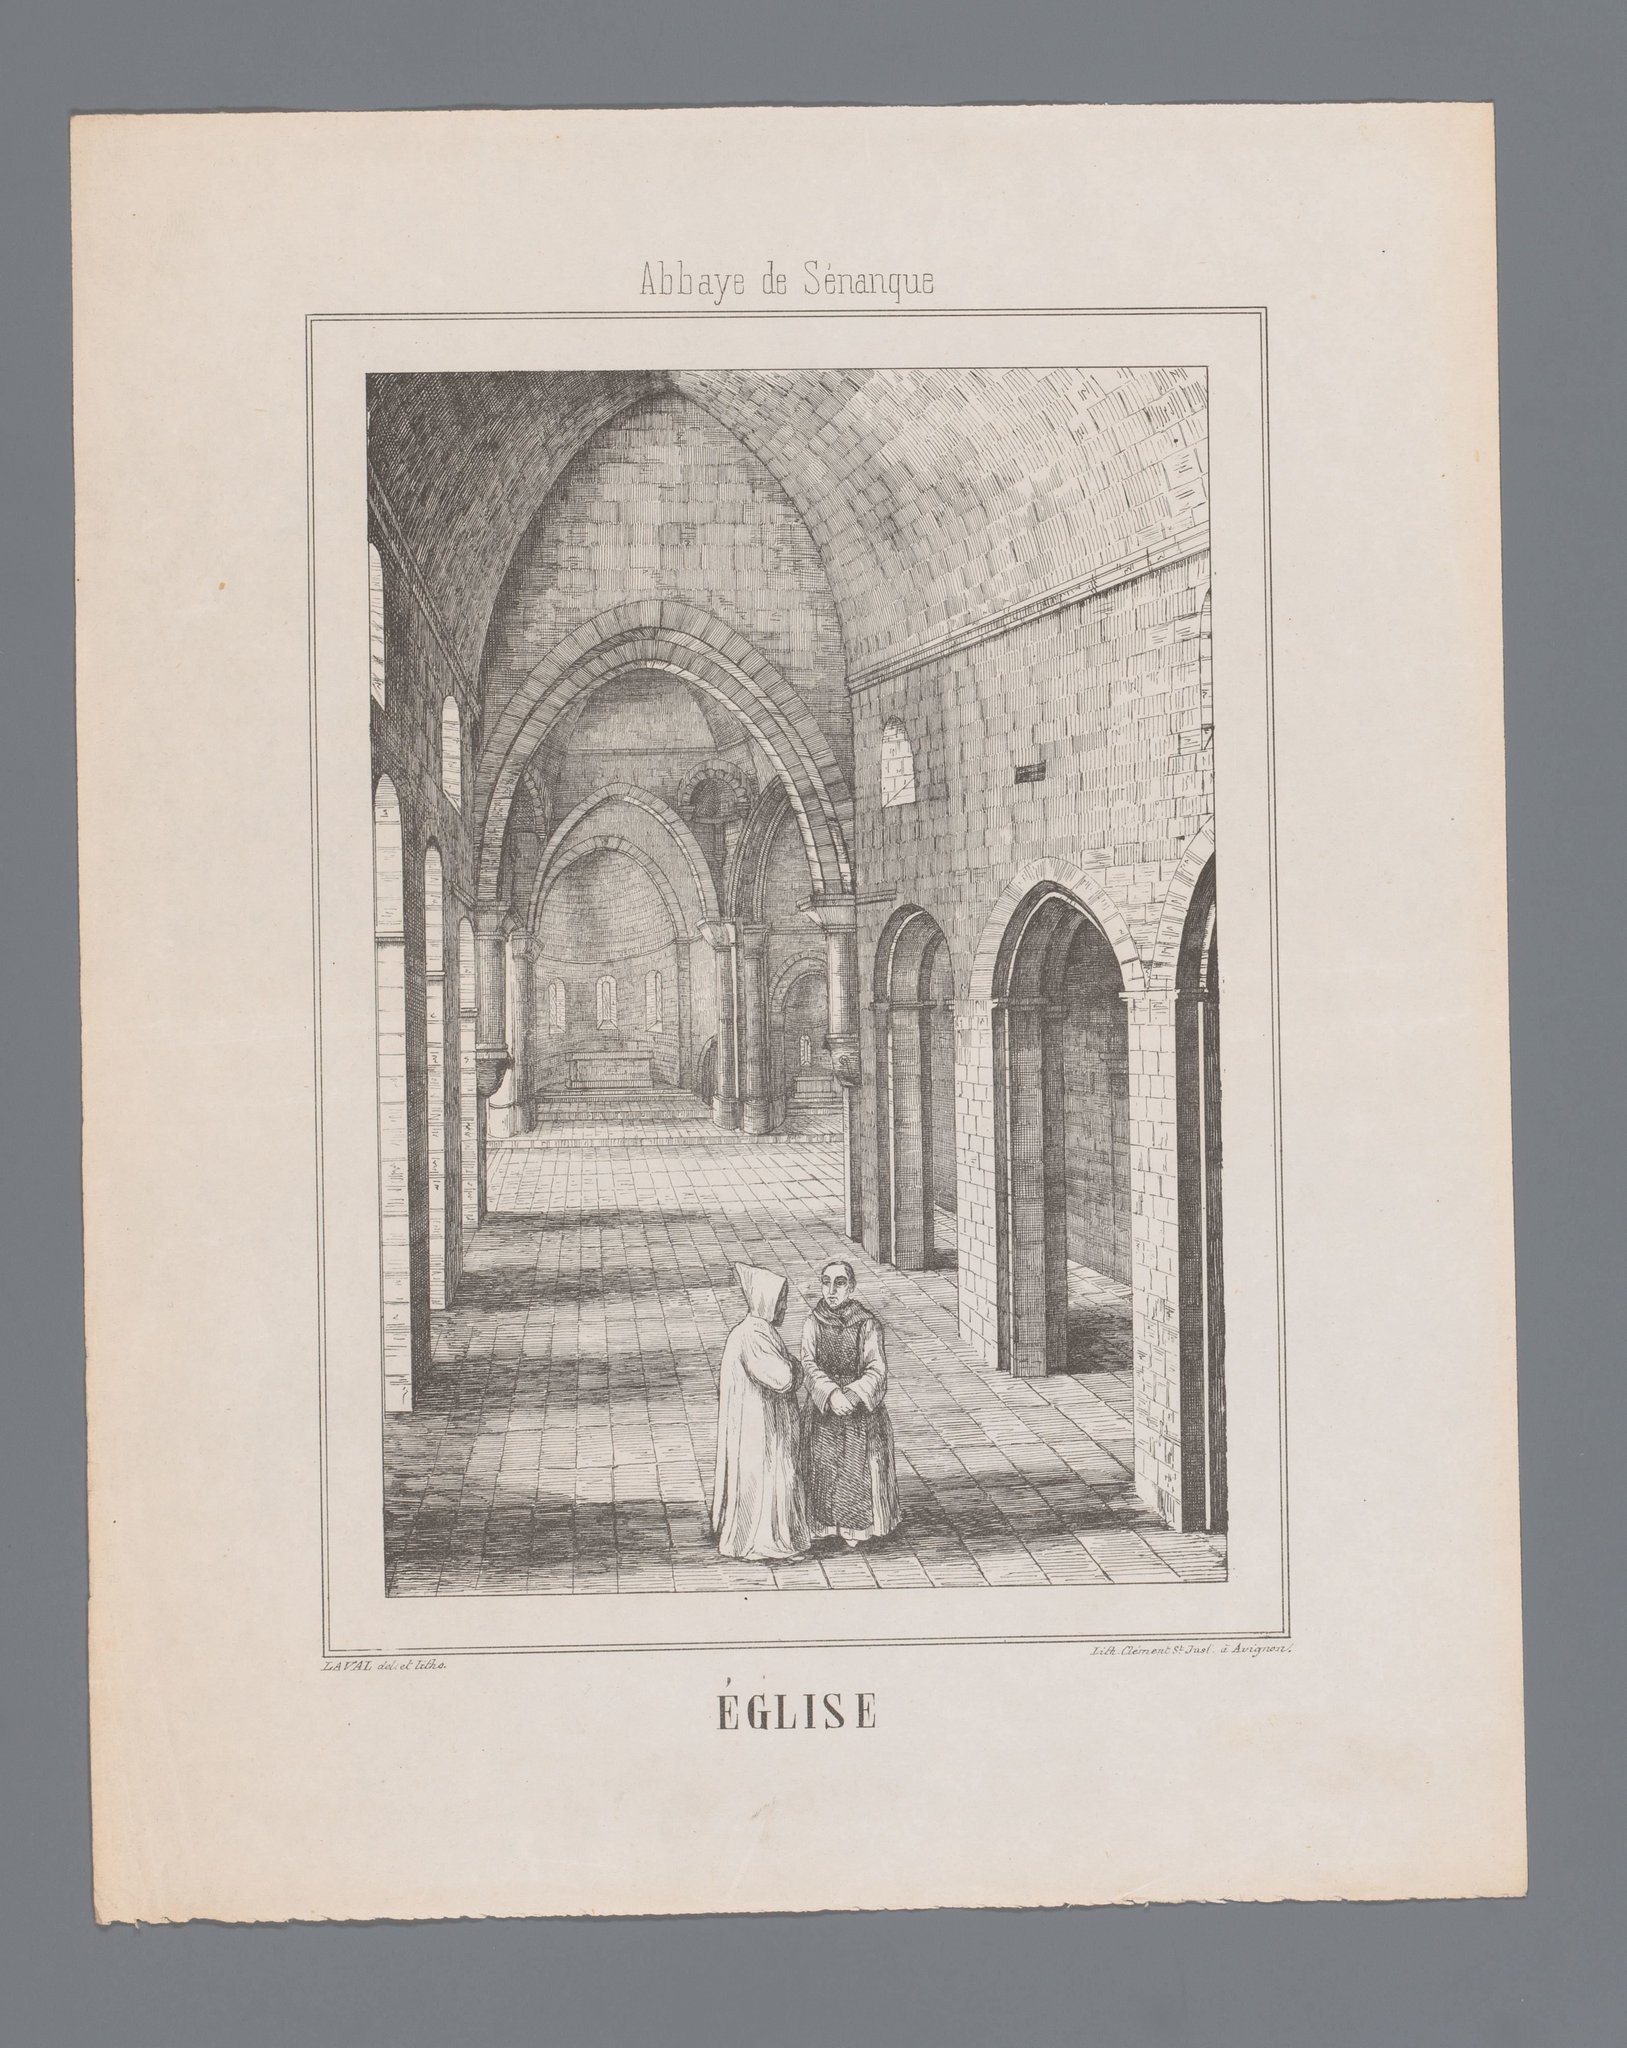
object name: print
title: Église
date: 1855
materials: paper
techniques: lithograph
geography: avignon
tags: abbey, monastery, convent ~ roman catholic church, interior of church